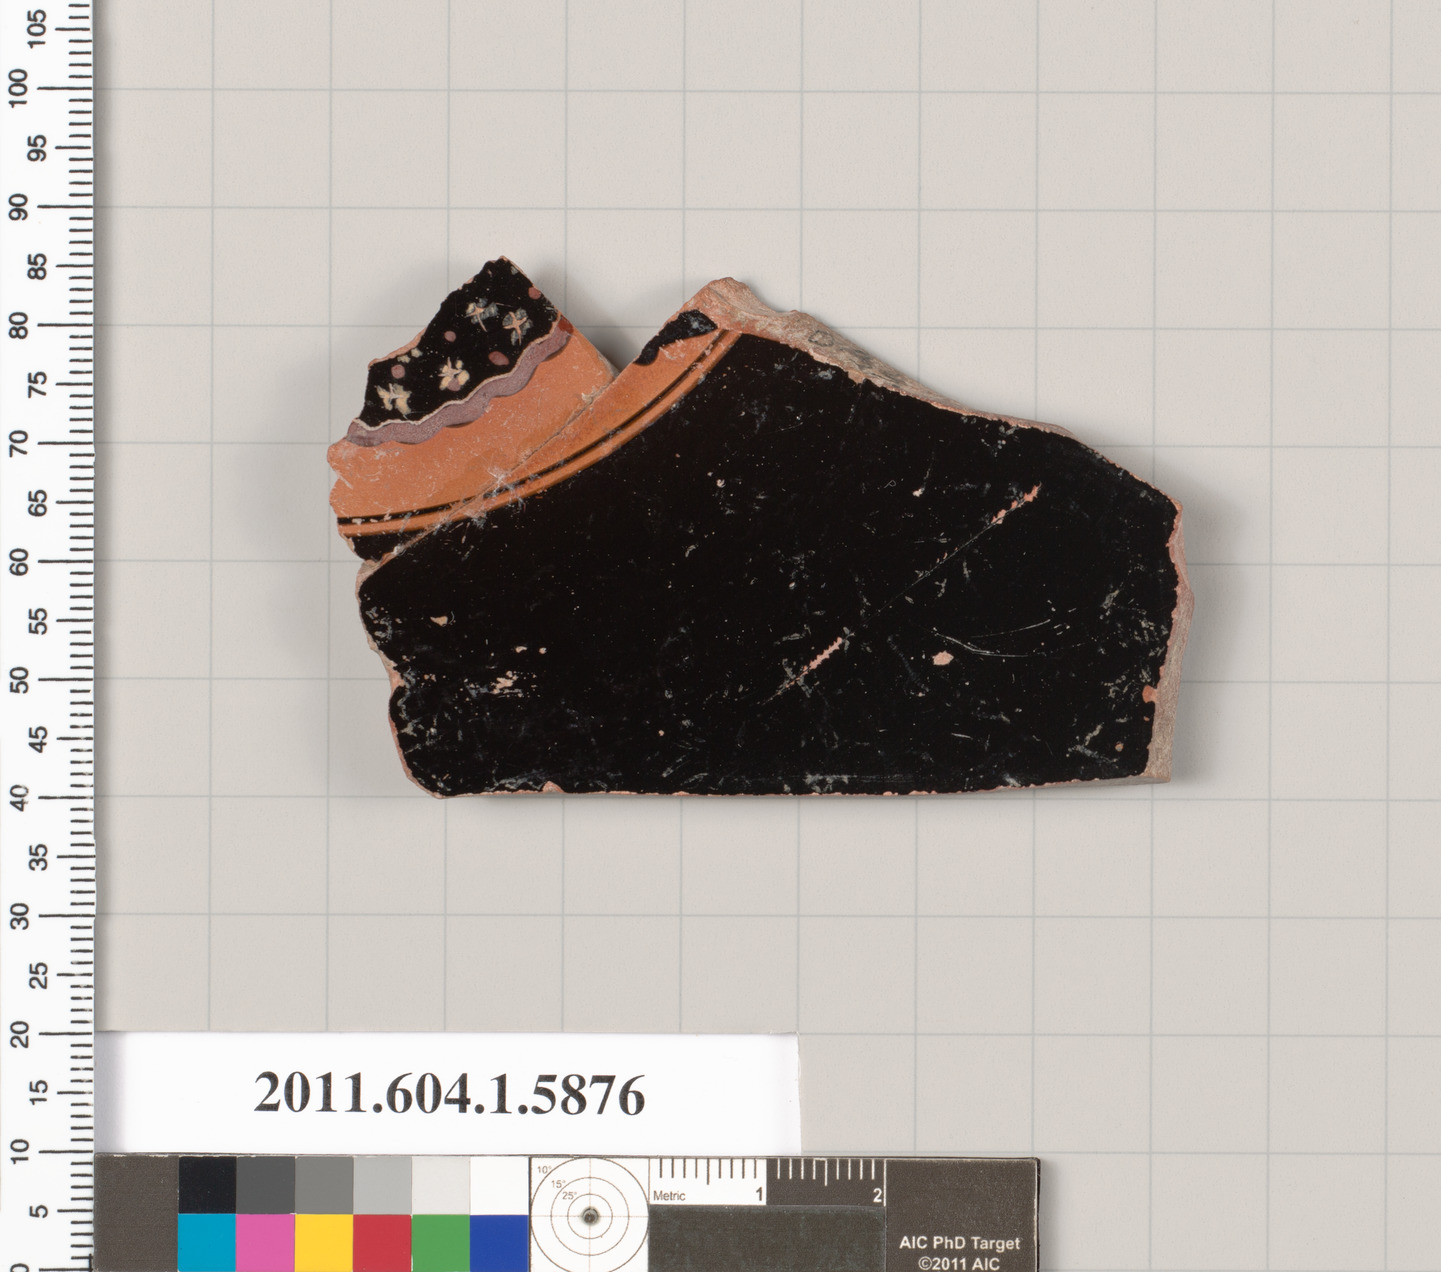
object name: kylix fragment, eye cup, bilingual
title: Terracotta fragment of a kylix (drinking cup)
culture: greek, attic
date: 433-567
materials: terracotta